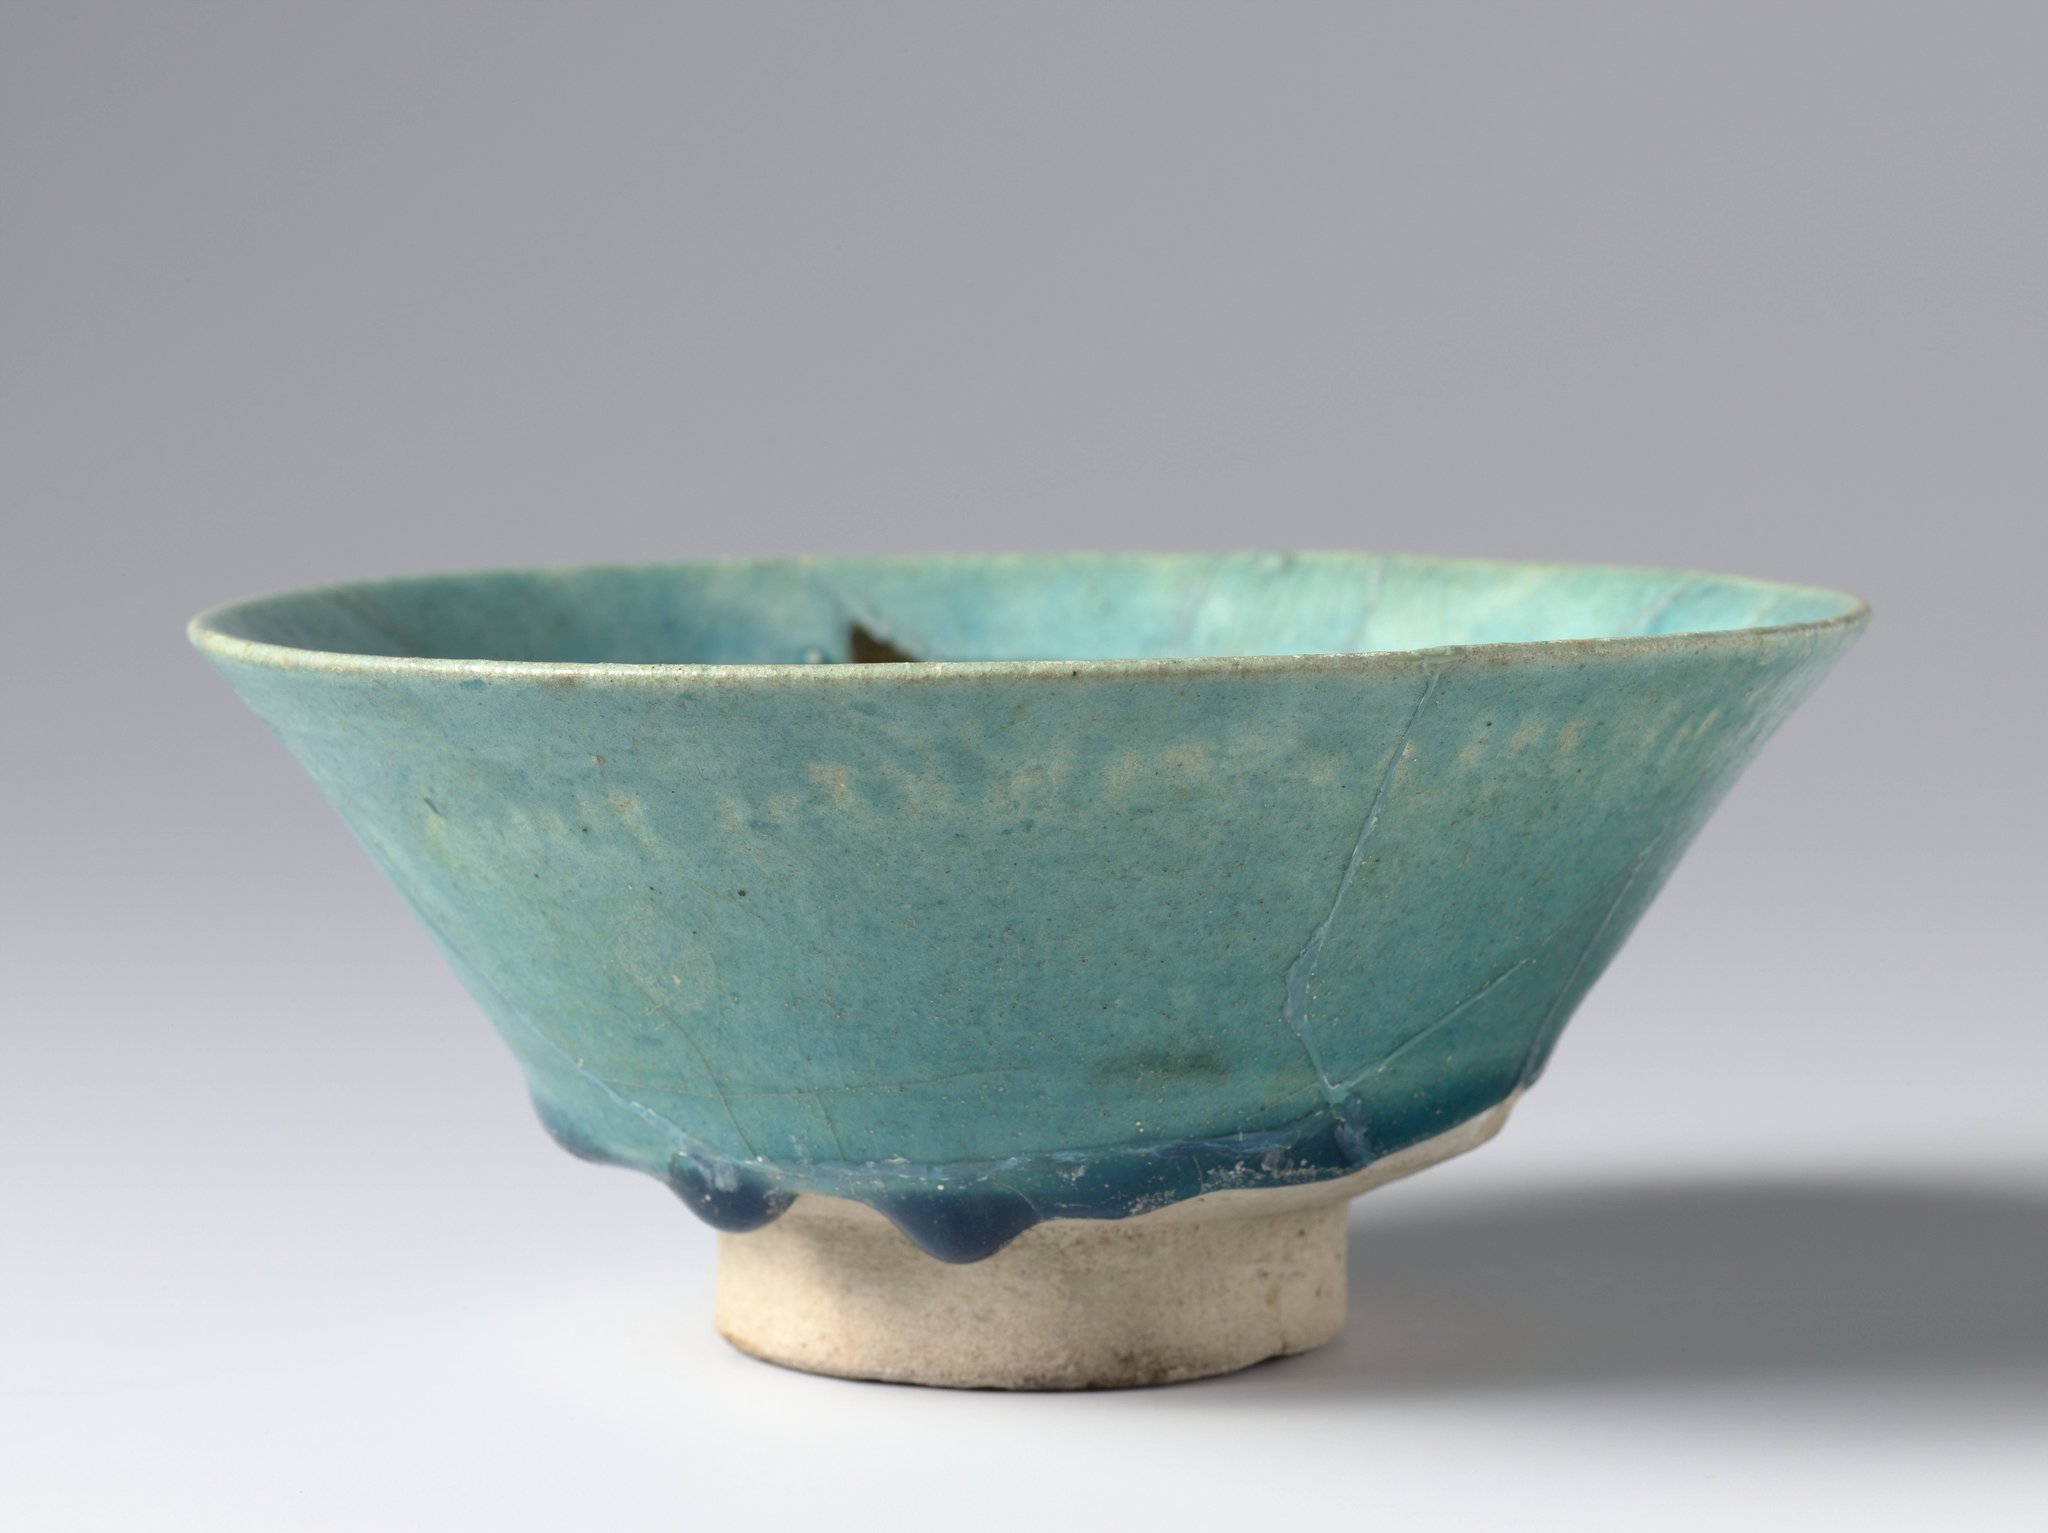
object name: bowl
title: Bowl with incised scrolls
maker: Anonymous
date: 1175-1224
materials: earthenware, glaze, quartz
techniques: engraving, firing, turning, vitrification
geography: iran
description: Kom van kwarts-fritgoed, gedecoreerd met een band met ingegrift krulwerk of (blad)ranken en bedekt met een monochrome turquoise alkaliglazuur.